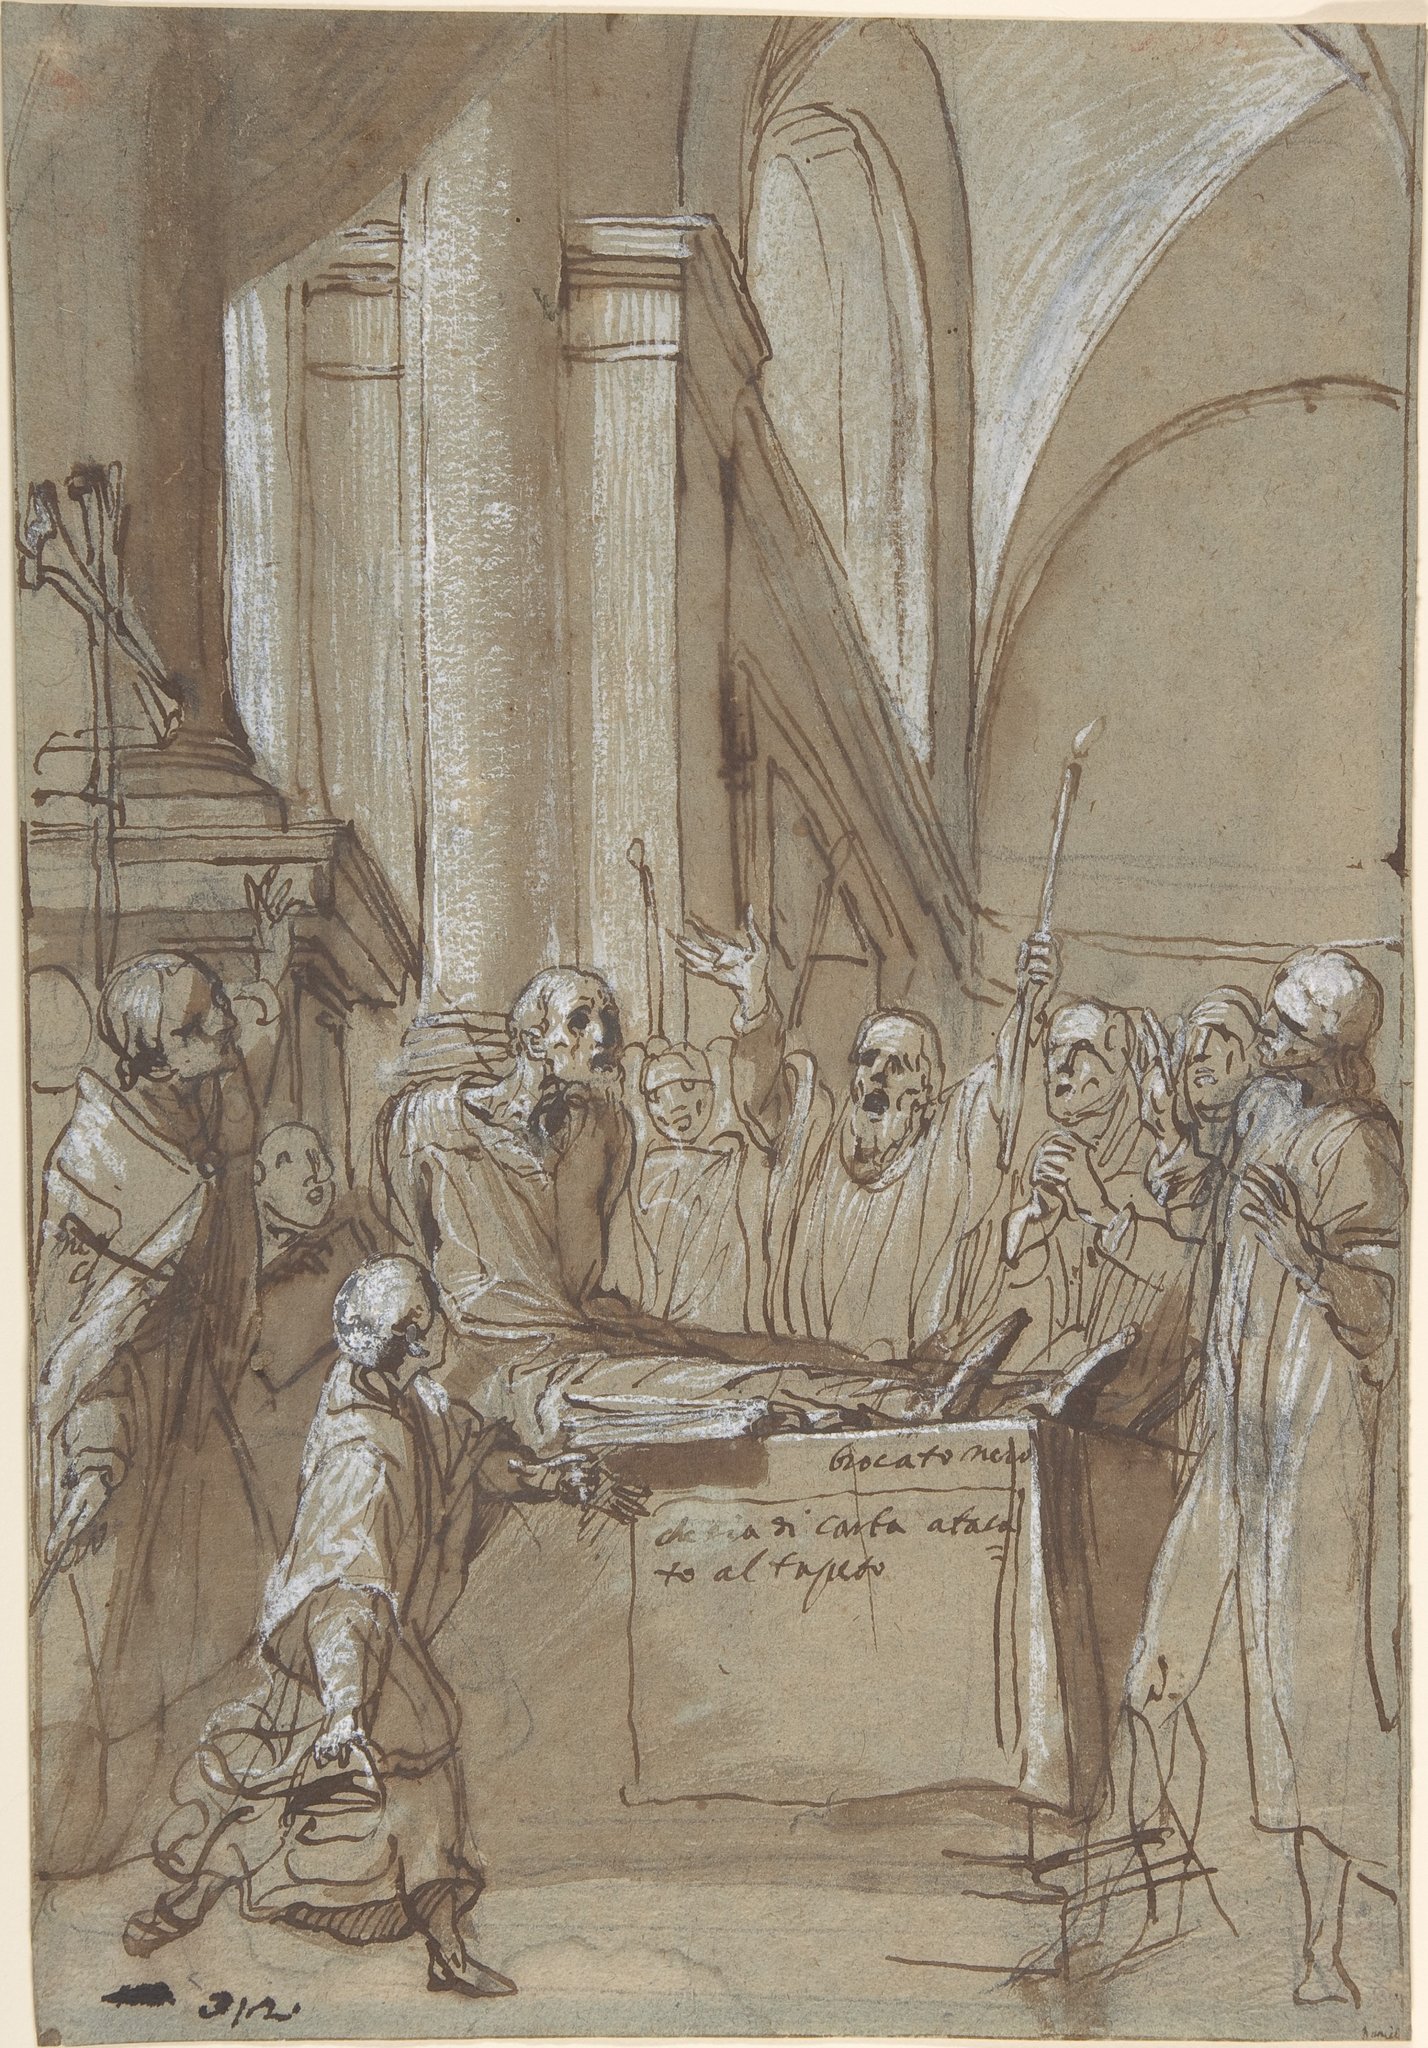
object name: drawing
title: Raymond Diocrès Speaking During His Funeral (from the Life of Saint Bruno of Cologne)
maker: daniele crespi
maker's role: artist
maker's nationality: italian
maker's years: 1597-1630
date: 1628-1629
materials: chalk, gouache, ink, drawing material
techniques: brush, highlighting, pen, wash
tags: funerals,crowd